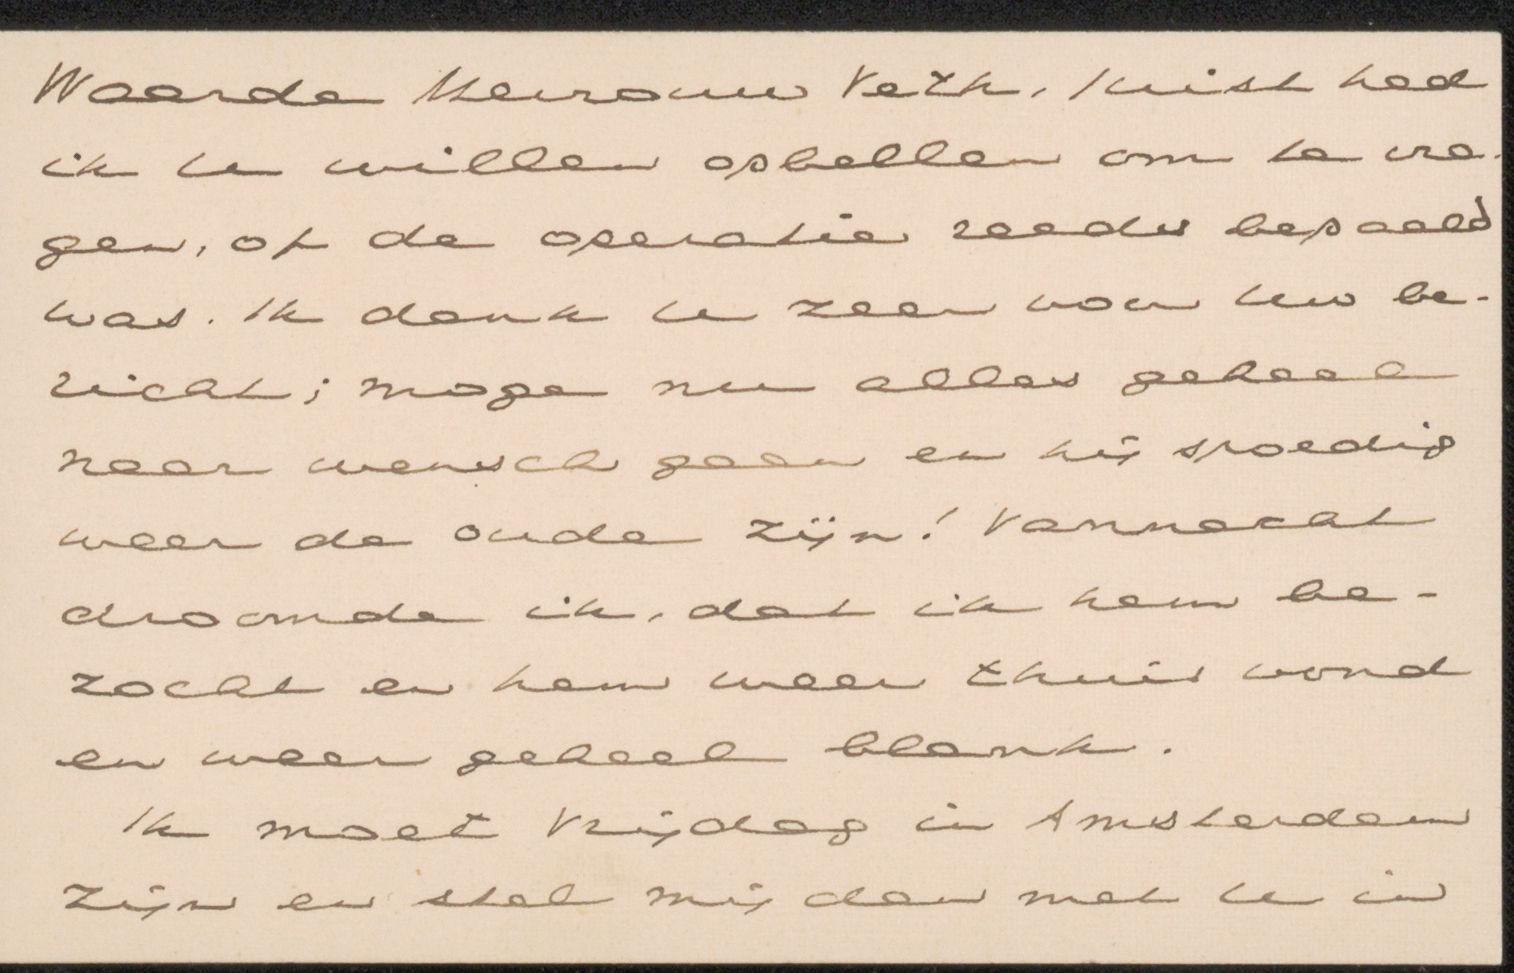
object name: letter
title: Brief aan Anna Dorothea Dirks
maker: johan huizinga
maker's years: 1872-1945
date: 1925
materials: ink, paper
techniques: pen, writing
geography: leiden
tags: artist, anna dorothea dirks, diseases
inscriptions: collector's mark: ‘RPK’